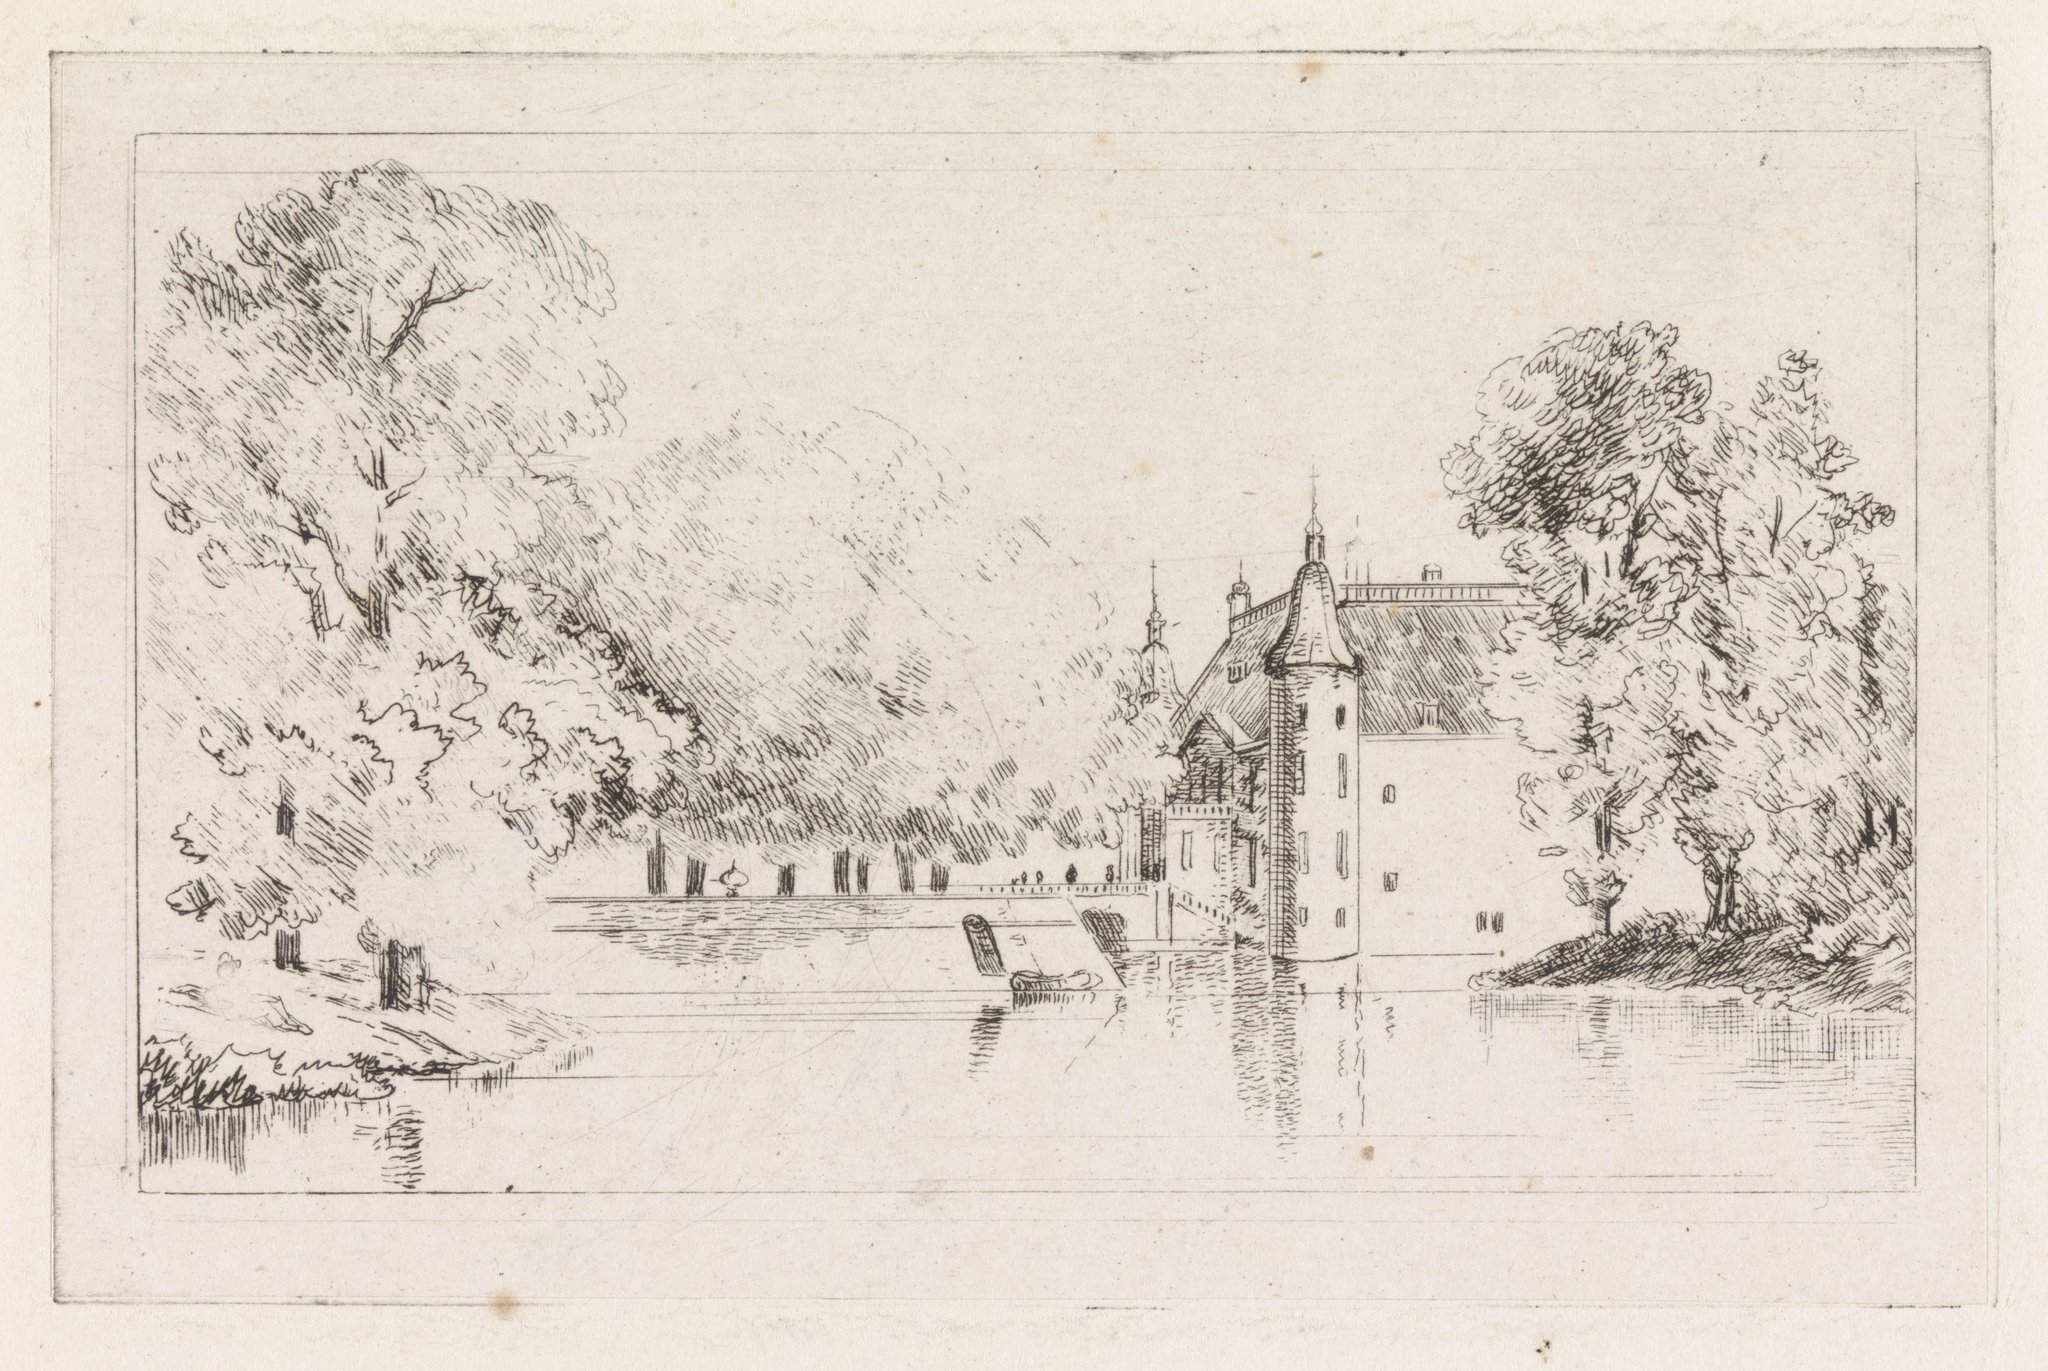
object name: print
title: Kasteel aan het water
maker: gijsbertus johannes verspuy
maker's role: print maker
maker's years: 1823-1862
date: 1861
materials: paper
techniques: etching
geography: netherlands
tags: castle, landscape with tower or castle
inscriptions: collector's mark: Lugt 2228, collector's mark: Lugt 1485